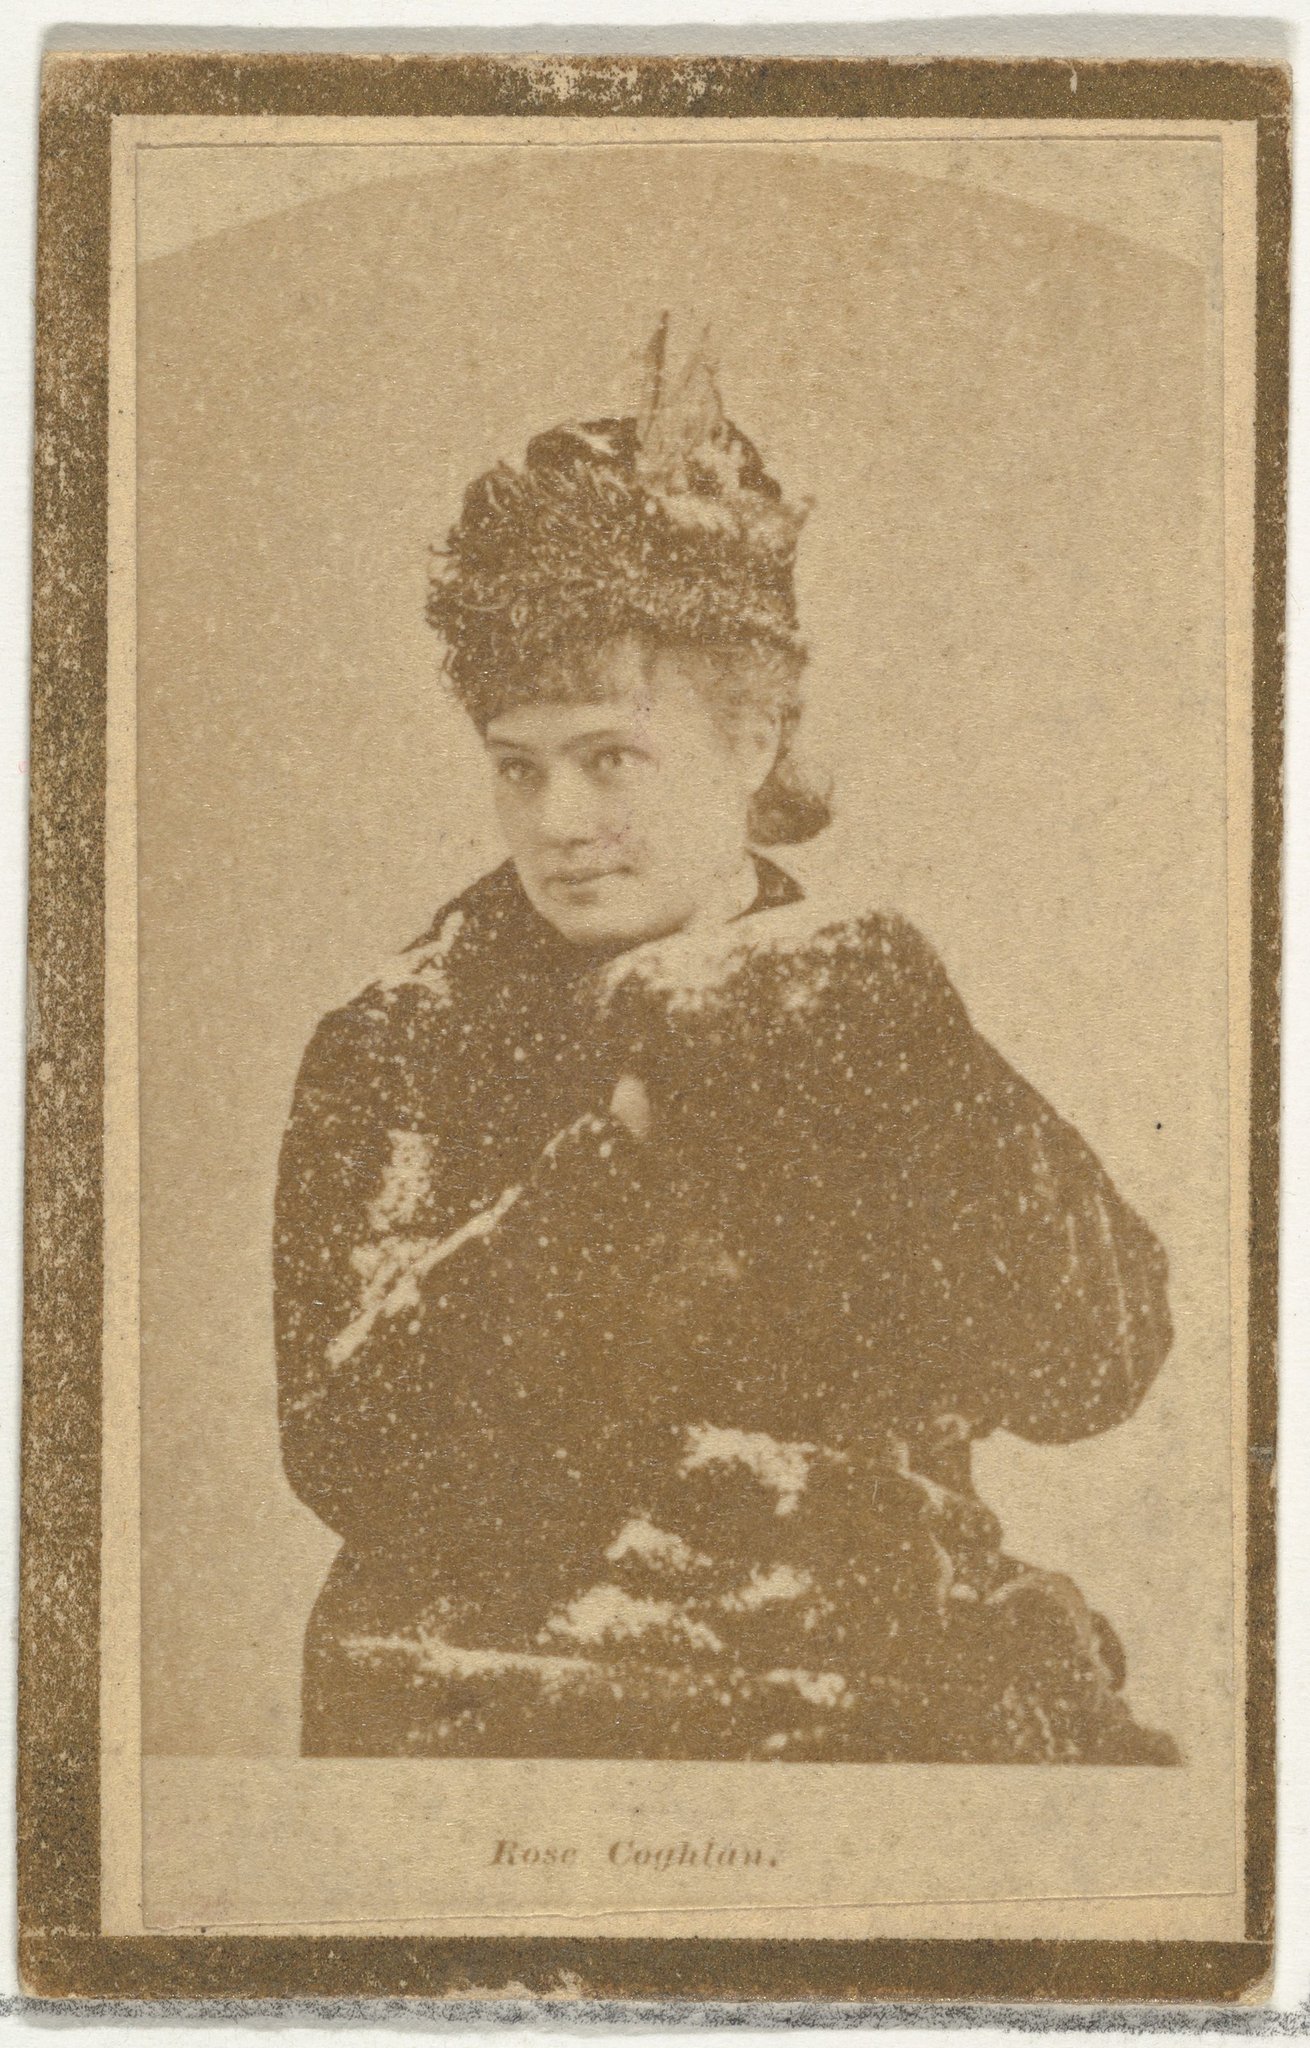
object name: photograph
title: Rose Coghlan, from the Actresses and Celebrities series (N60, Type 2) promoting Little Beauties Cigarettes for Allen & Ginter brand tobacco products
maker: allen & ginter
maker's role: publisher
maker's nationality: american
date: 1887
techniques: albumen silver print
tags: portraits,women,actresses